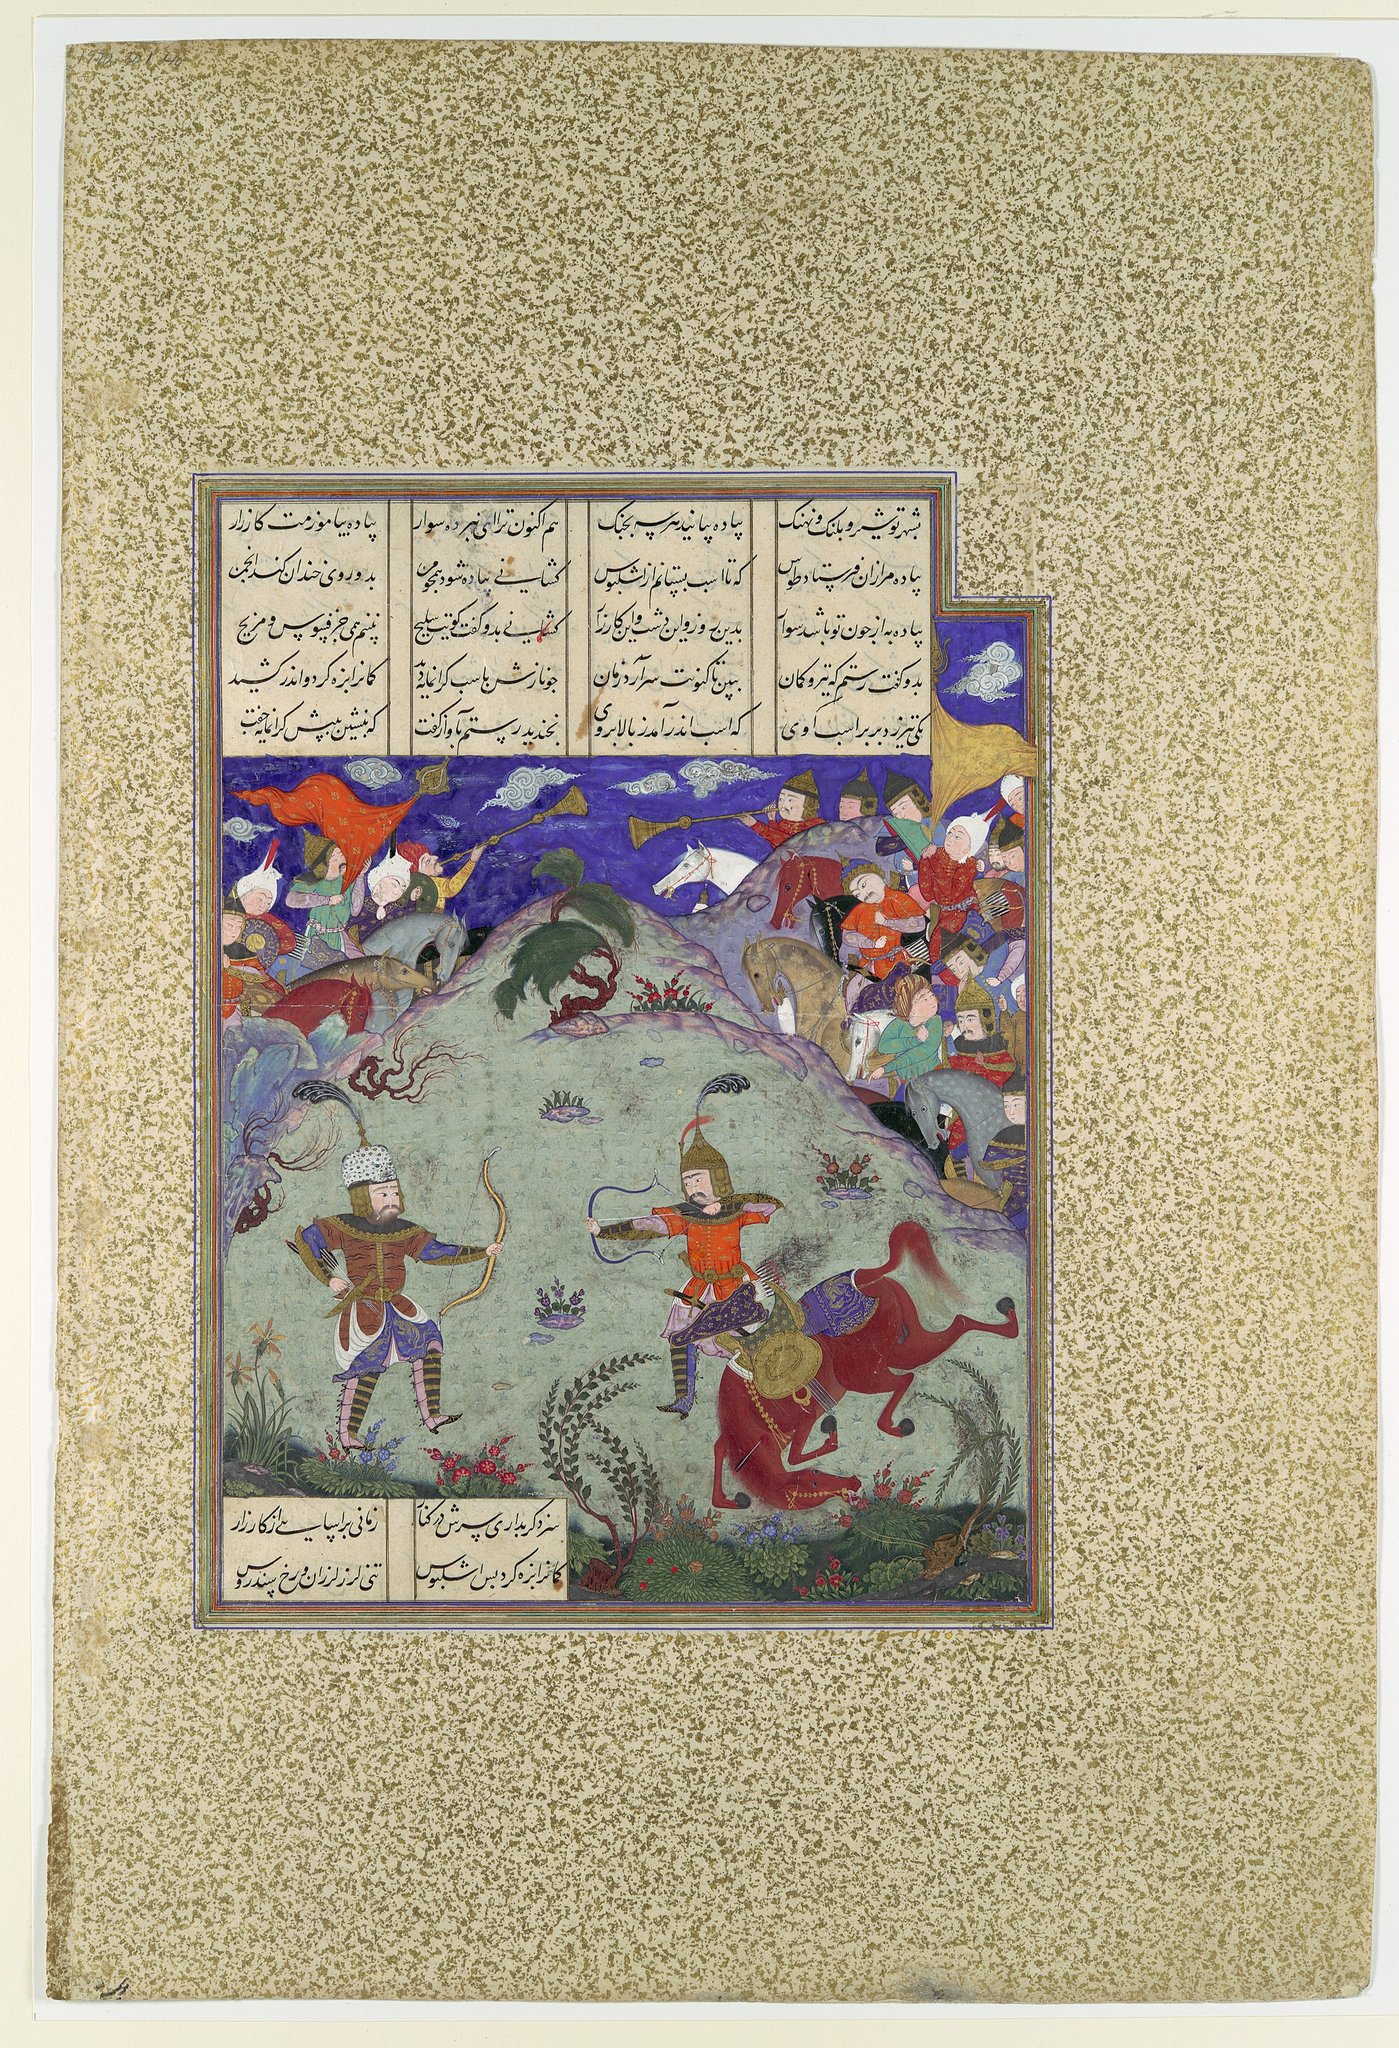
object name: folio from an illustrated manuscript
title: "The Combat of Rustam and Ashkabus", Folio 268v from the Shahnama (Book of Kings) of Shah Tahmasp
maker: abu'l qasim firdausi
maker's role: author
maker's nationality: iranian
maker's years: 935-1020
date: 1525-1530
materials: gold, ink, paper, silver, watercolor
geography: iran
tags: battles,weapons,men,horses